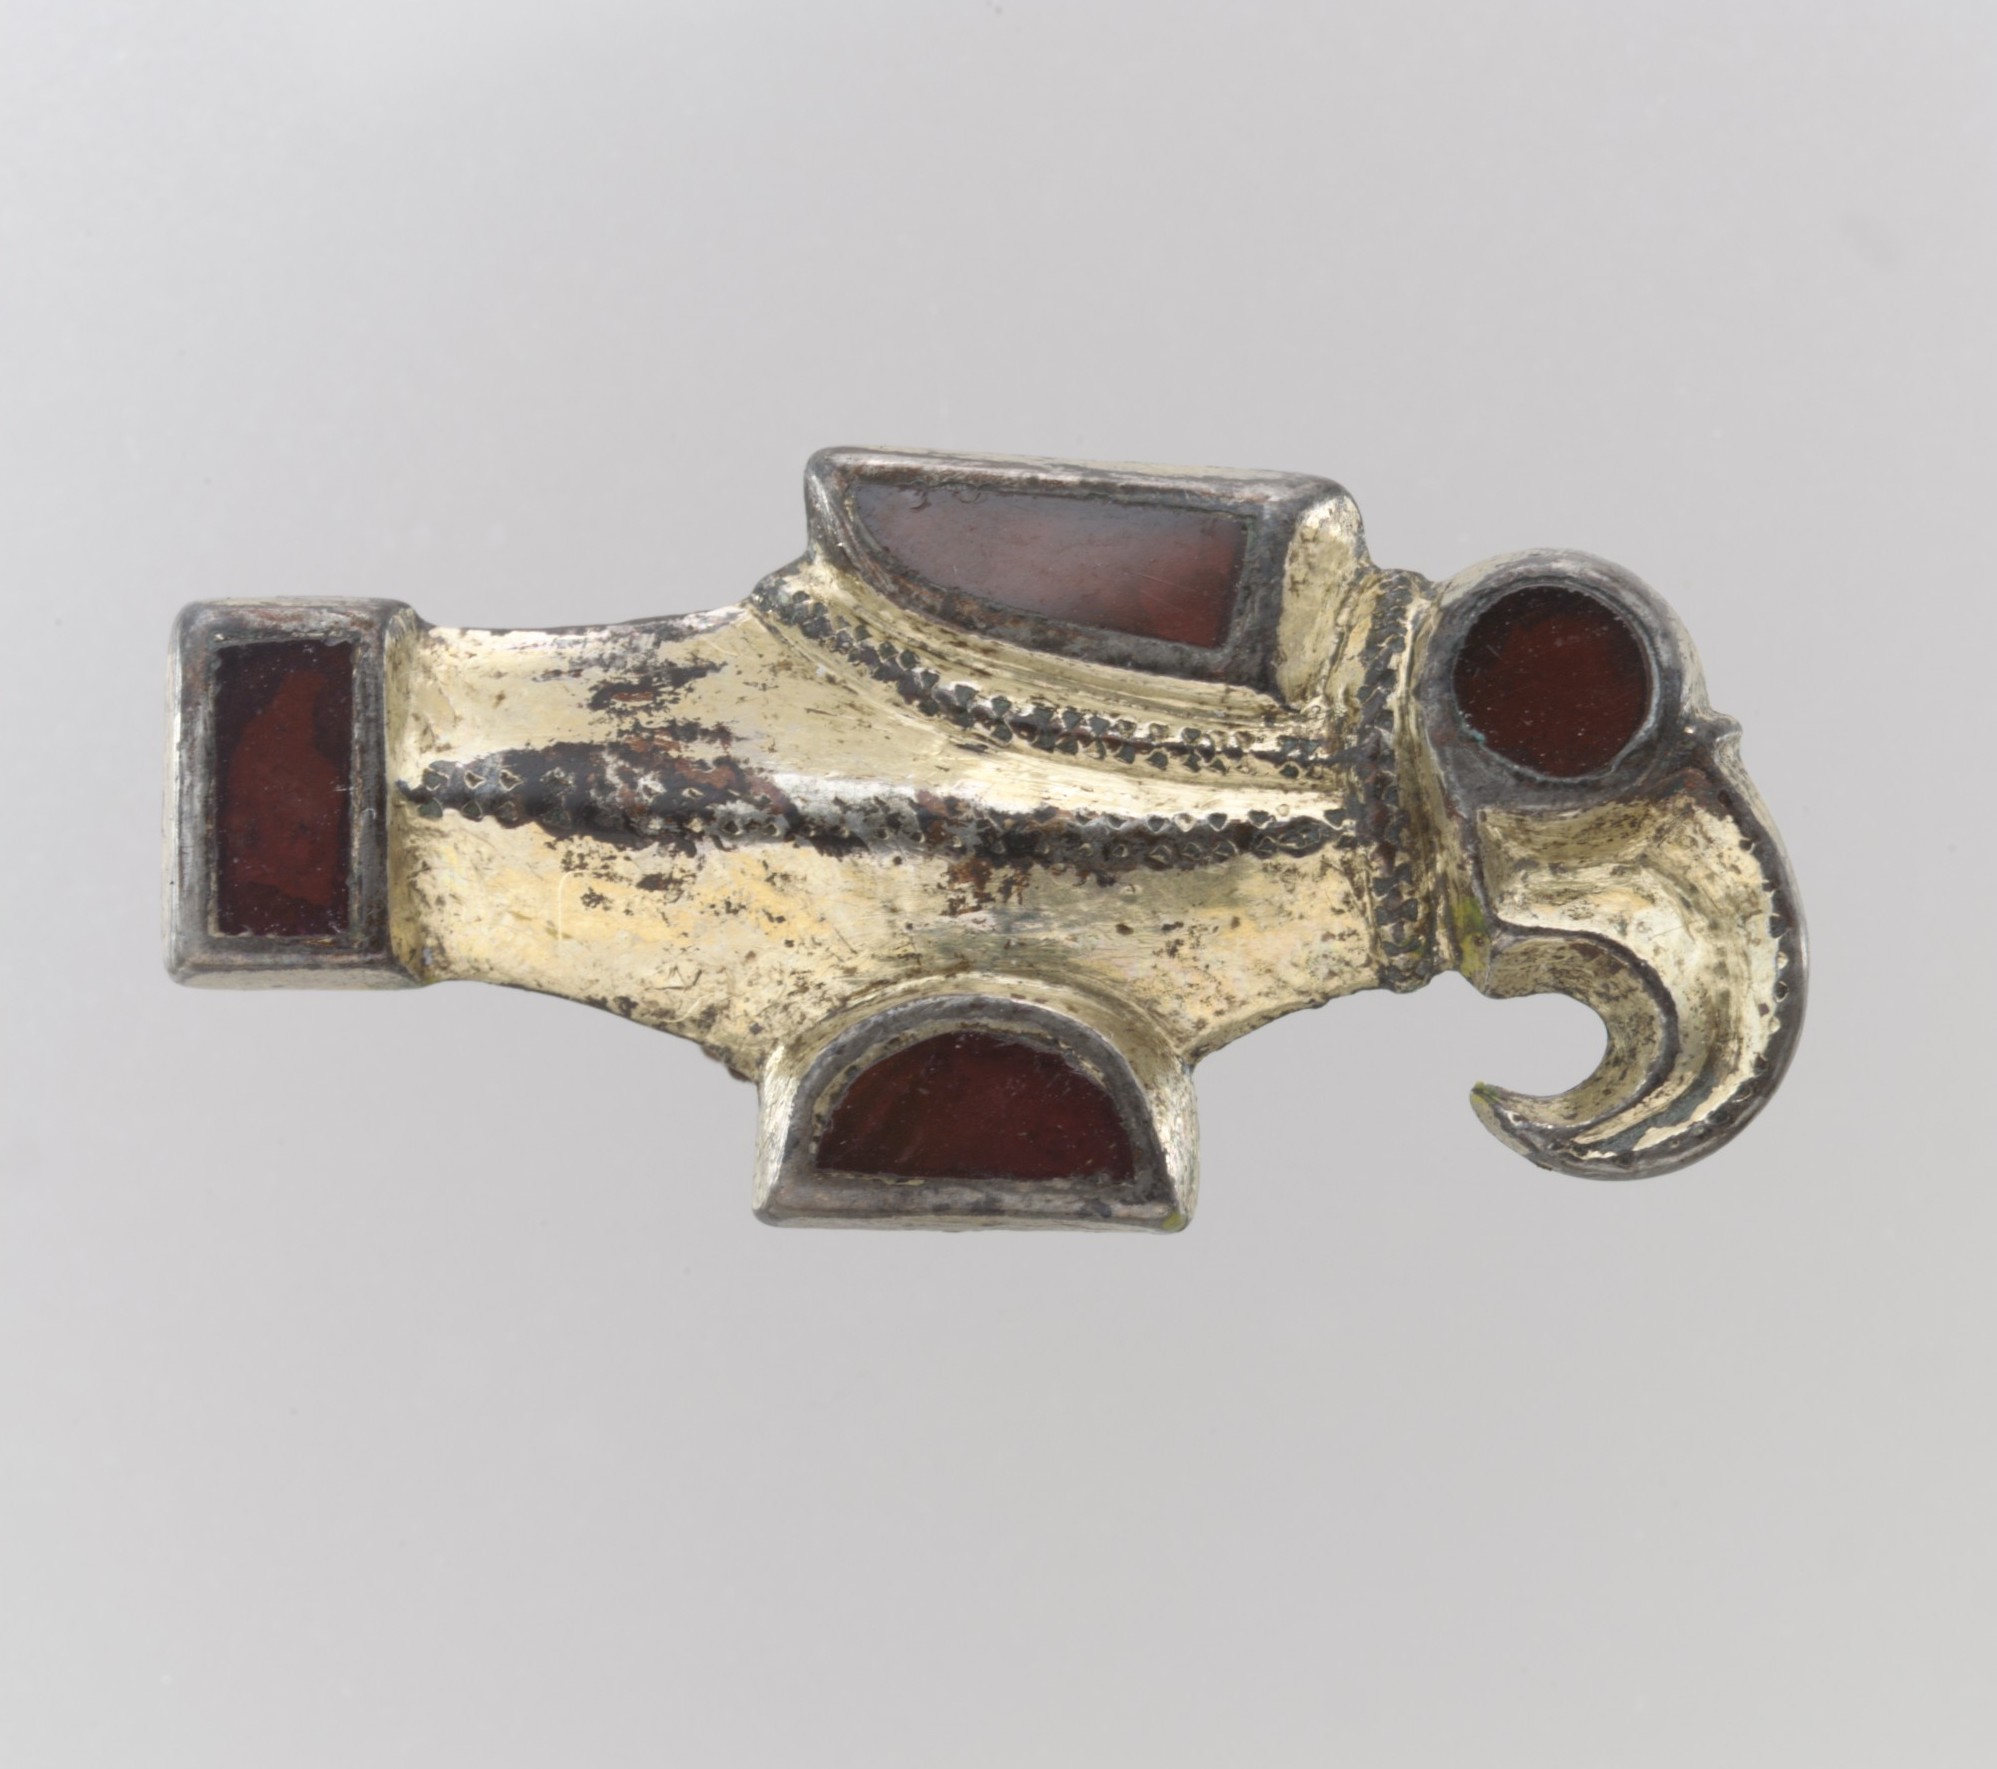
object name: brooch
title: Bird-Shaped Brooch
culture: frankish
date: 500-600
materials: foil, garnet, iron, silver gilt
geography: northern france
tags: birds